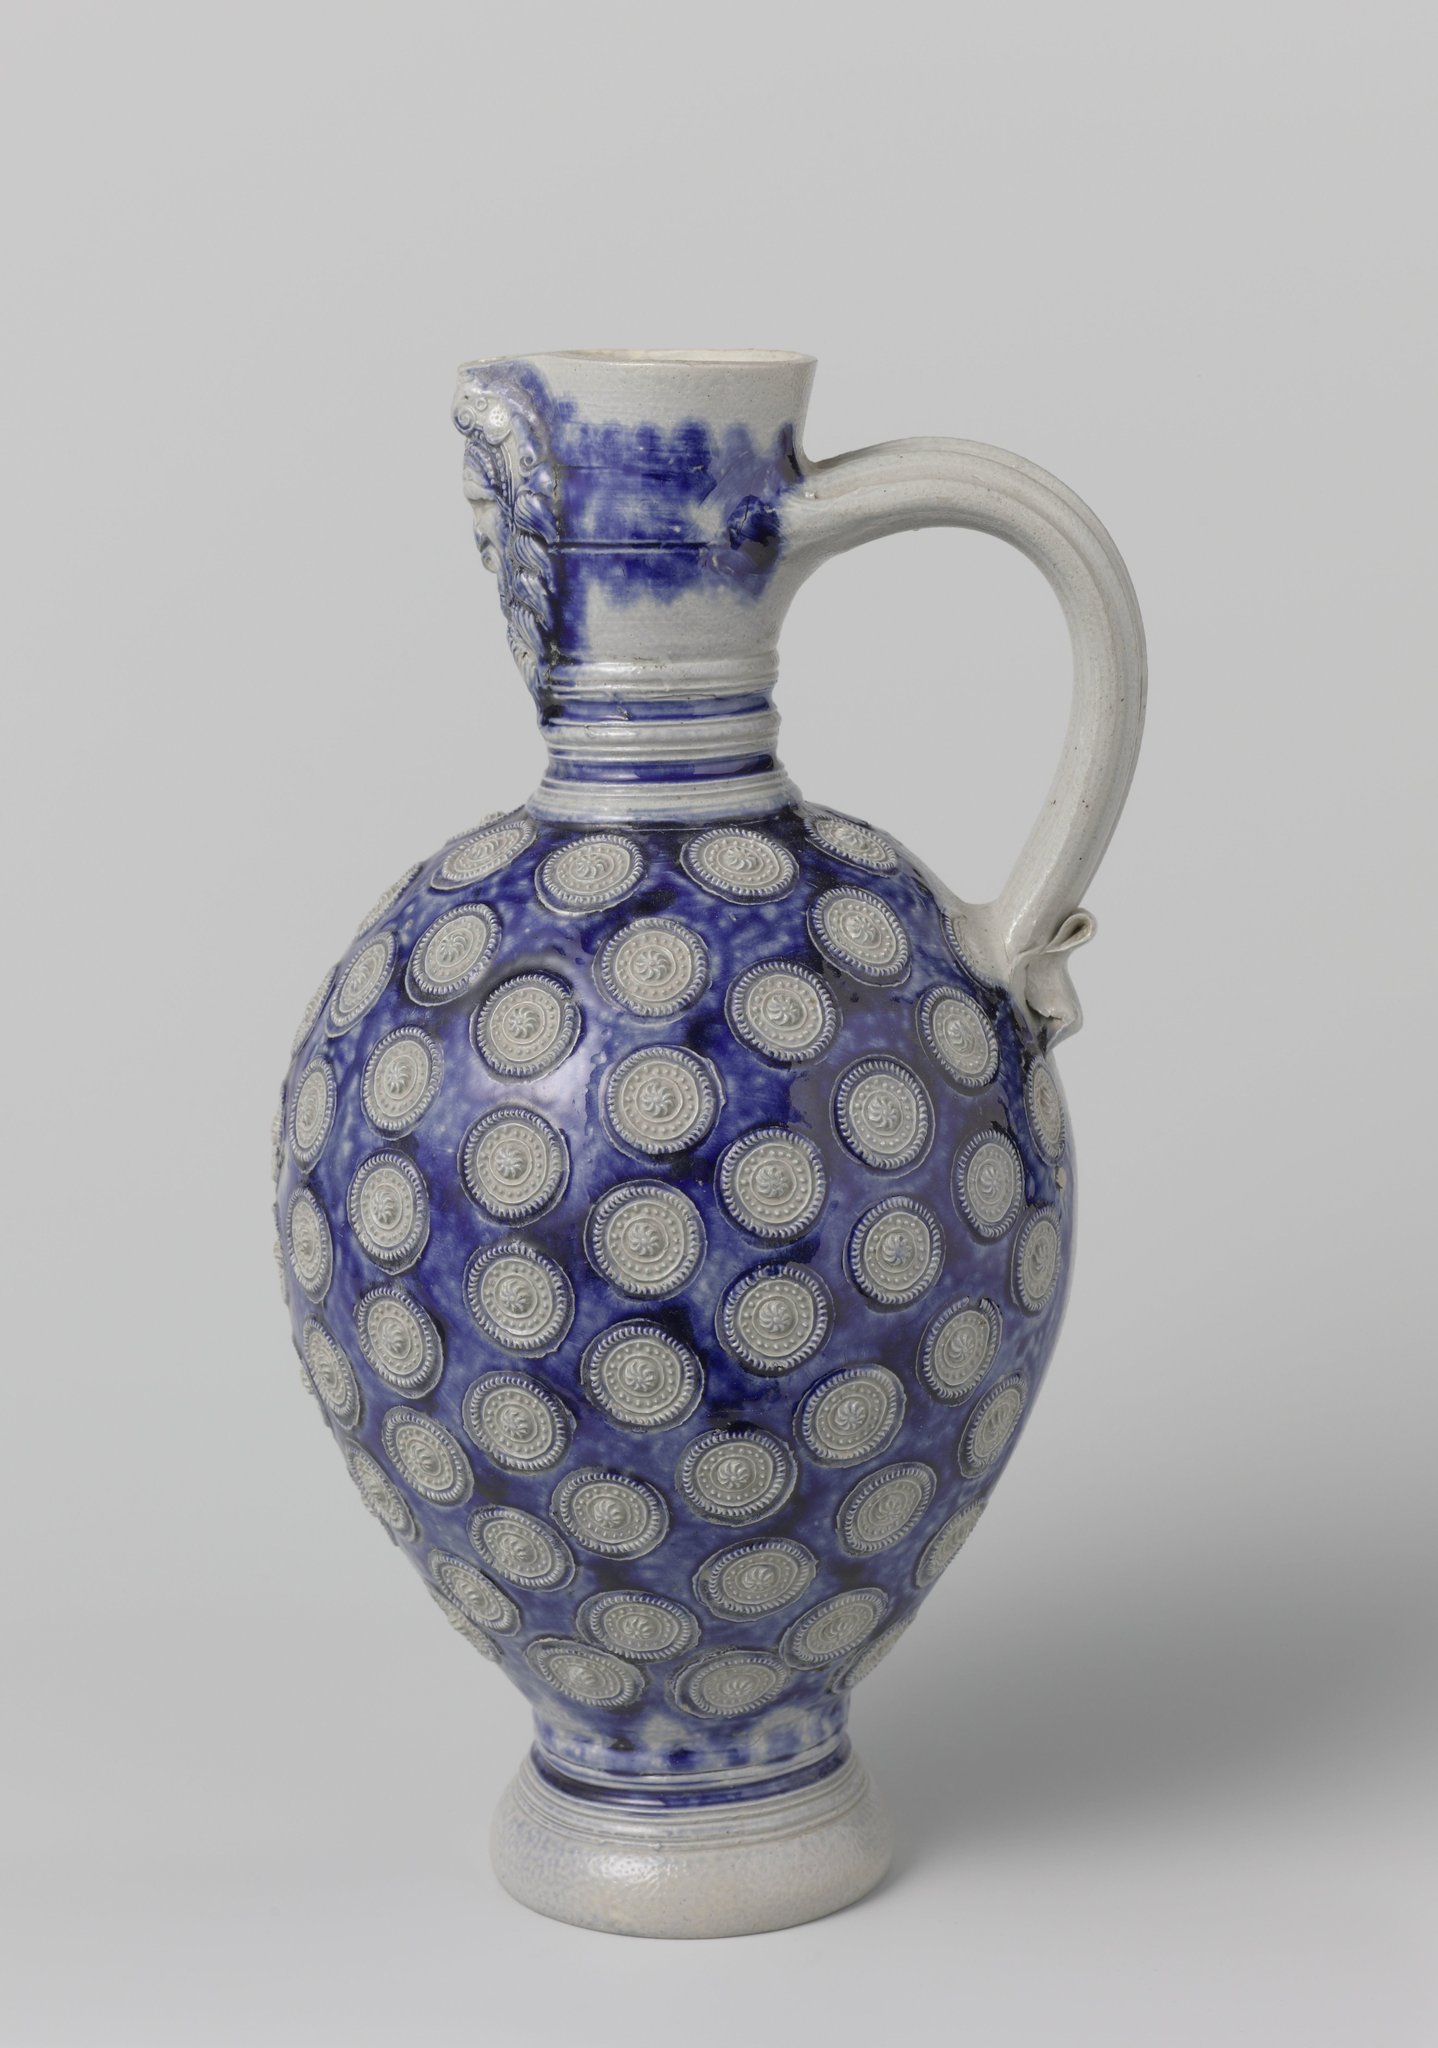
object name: ewer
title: Jug with a lion's head and medallions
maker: Anonymous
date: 1630-1660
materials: cobalt, glaze, stoneware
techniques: firing, forming, relief, turning, vitrification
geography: westerwald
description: Kan van steengoed op hoge voet met een smalle nek, eivormig lichaam en in de rand een geknepen tuit. Het C-vormige oor is bevestigd aan de nek en de schouder. Gedeeltelijk bedekt met kobaltblauw. Op de voet en de nek enkele profielen. De kan is versierd met een reliëfdecoratie waarbij de buik grotendeels is bedekt met gedrukte, opgelegde medaillons met een bloemrozet tegen een blauwe achtergrond. Op de nek onder de tuit is een gemodelleerde leeuwenkop aangebracht. Westerwald.